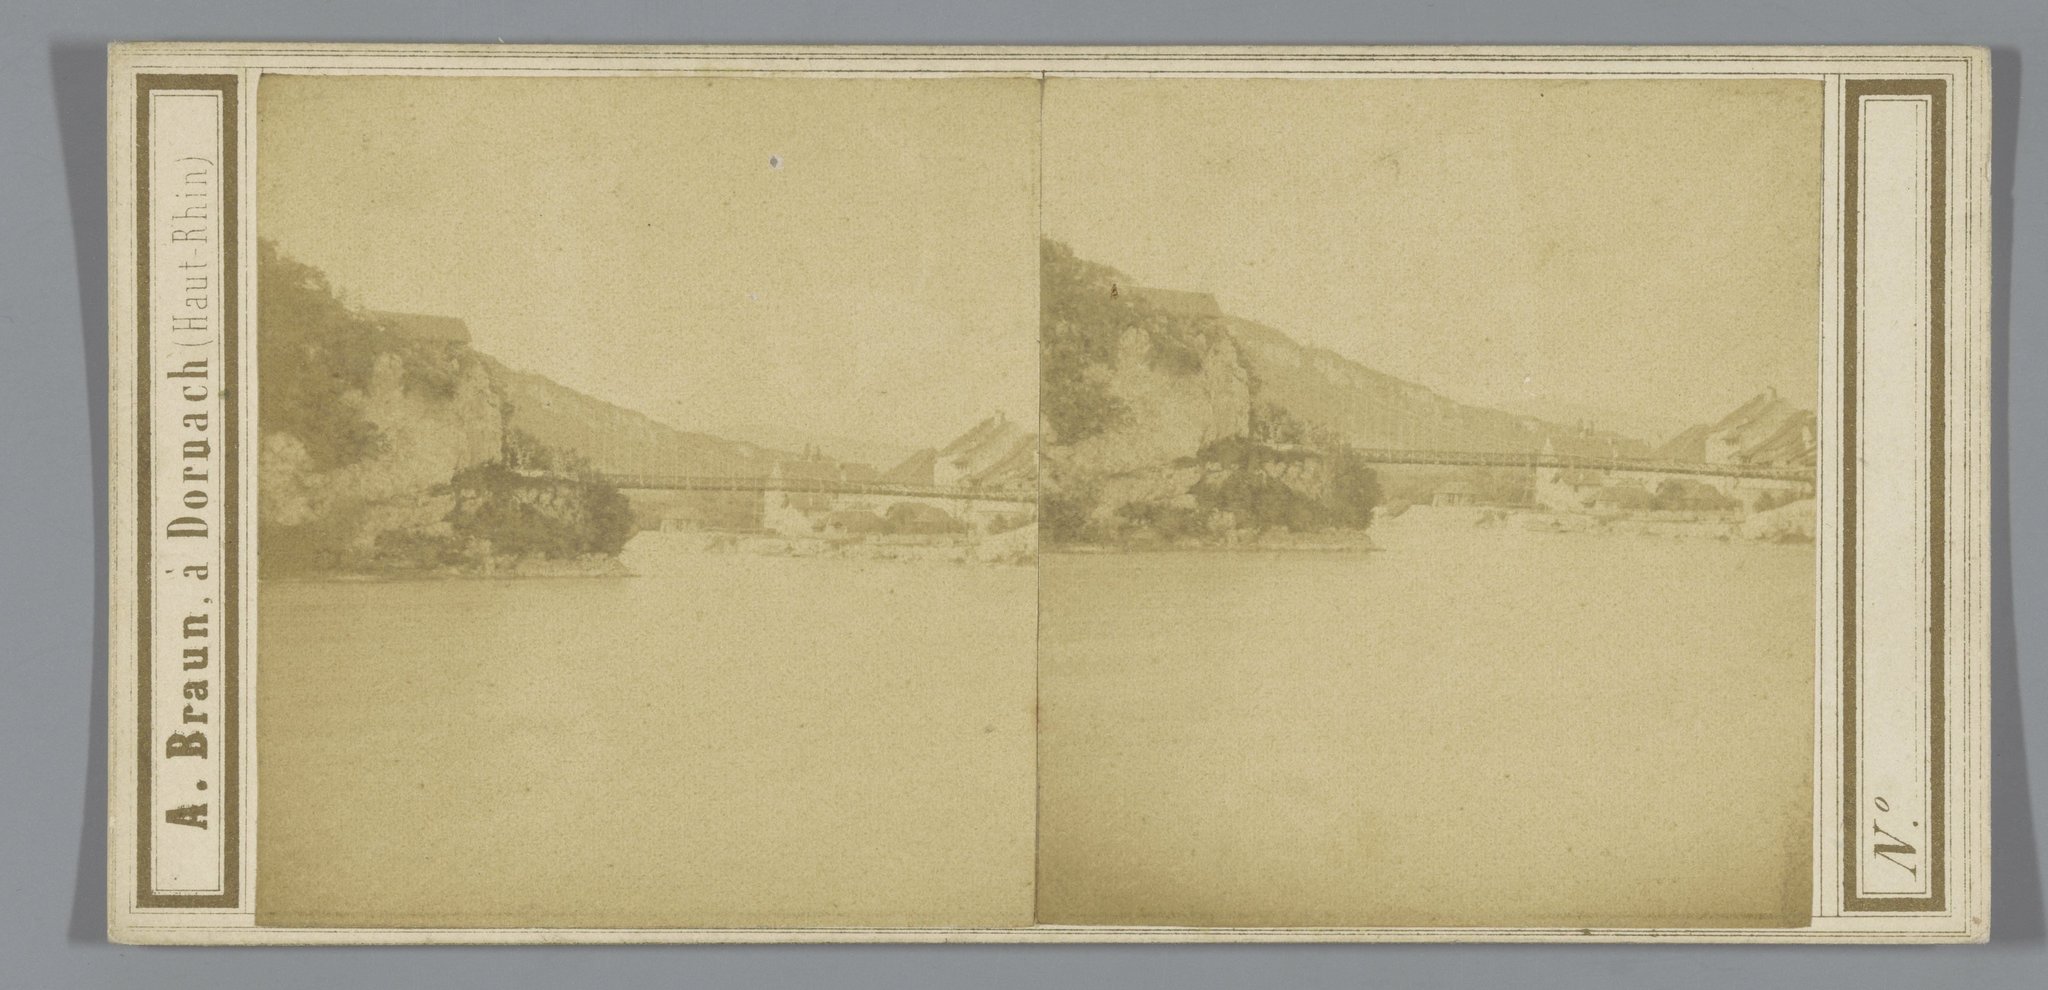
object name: stereograph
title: Aarbourg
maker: Anonymous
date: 1860-1866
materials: cardboard, paper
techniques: albumen print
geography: aarburg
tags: bridge in city across river, canal, etc.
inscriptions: number: ‘472.’